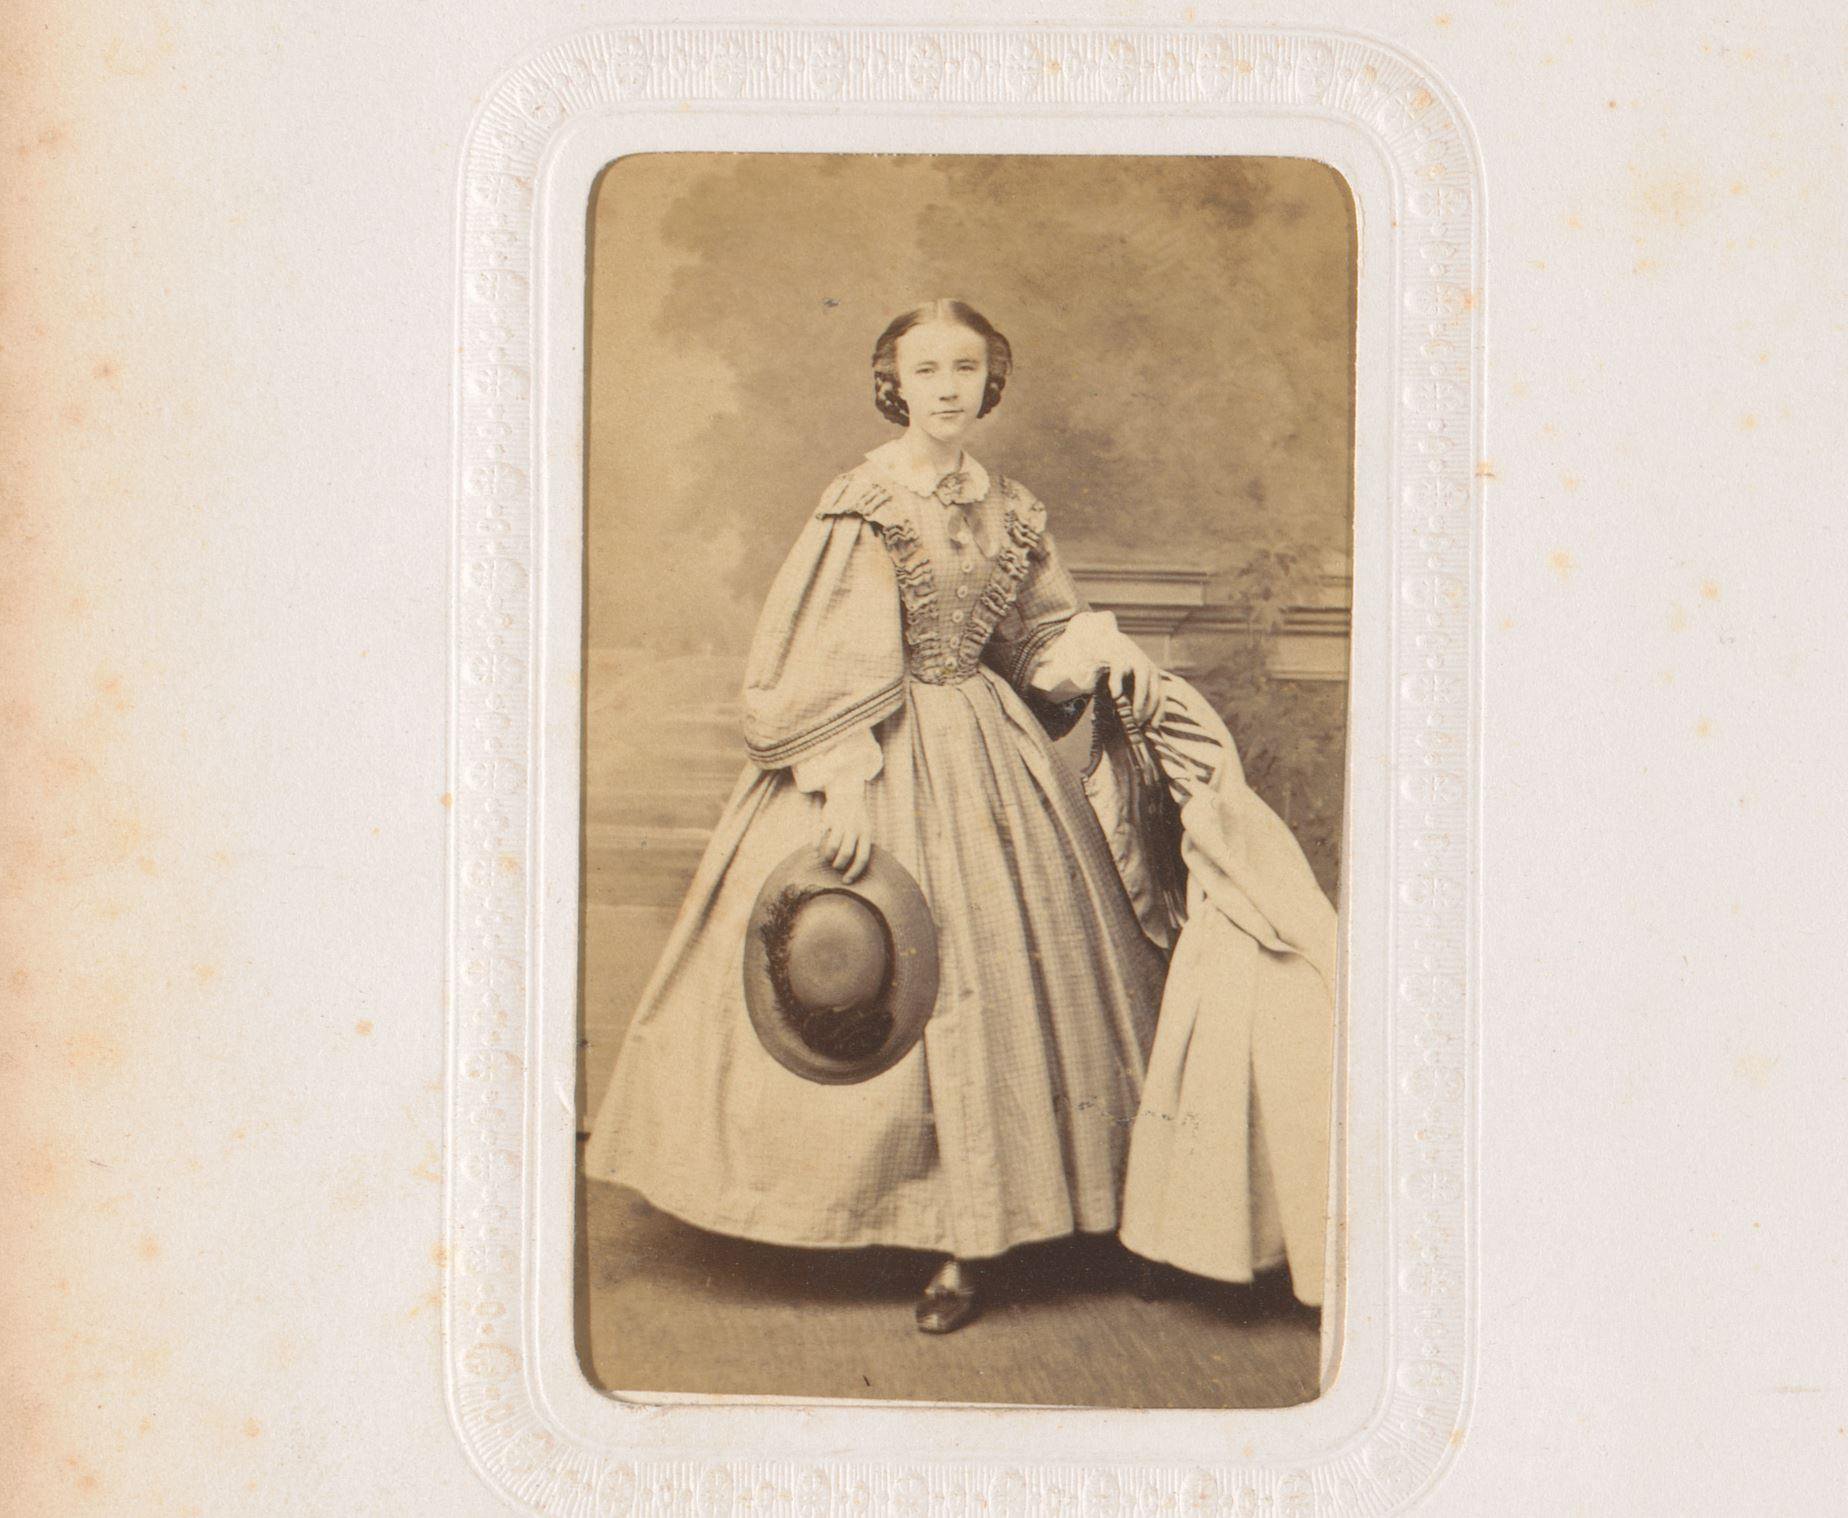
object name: album leaf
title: Portret van een jonge vrouw met hoed in de hand, staand bij een stoel waarop een mantel ligt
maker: Anonymous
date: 1860-1900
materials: cardboard, photographic support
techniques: albumen print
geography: netherlands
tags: adolescent, young woman, maiden, historical persons - bb - woman, head-gear: hat, standing figure - aa - female human figure, chair